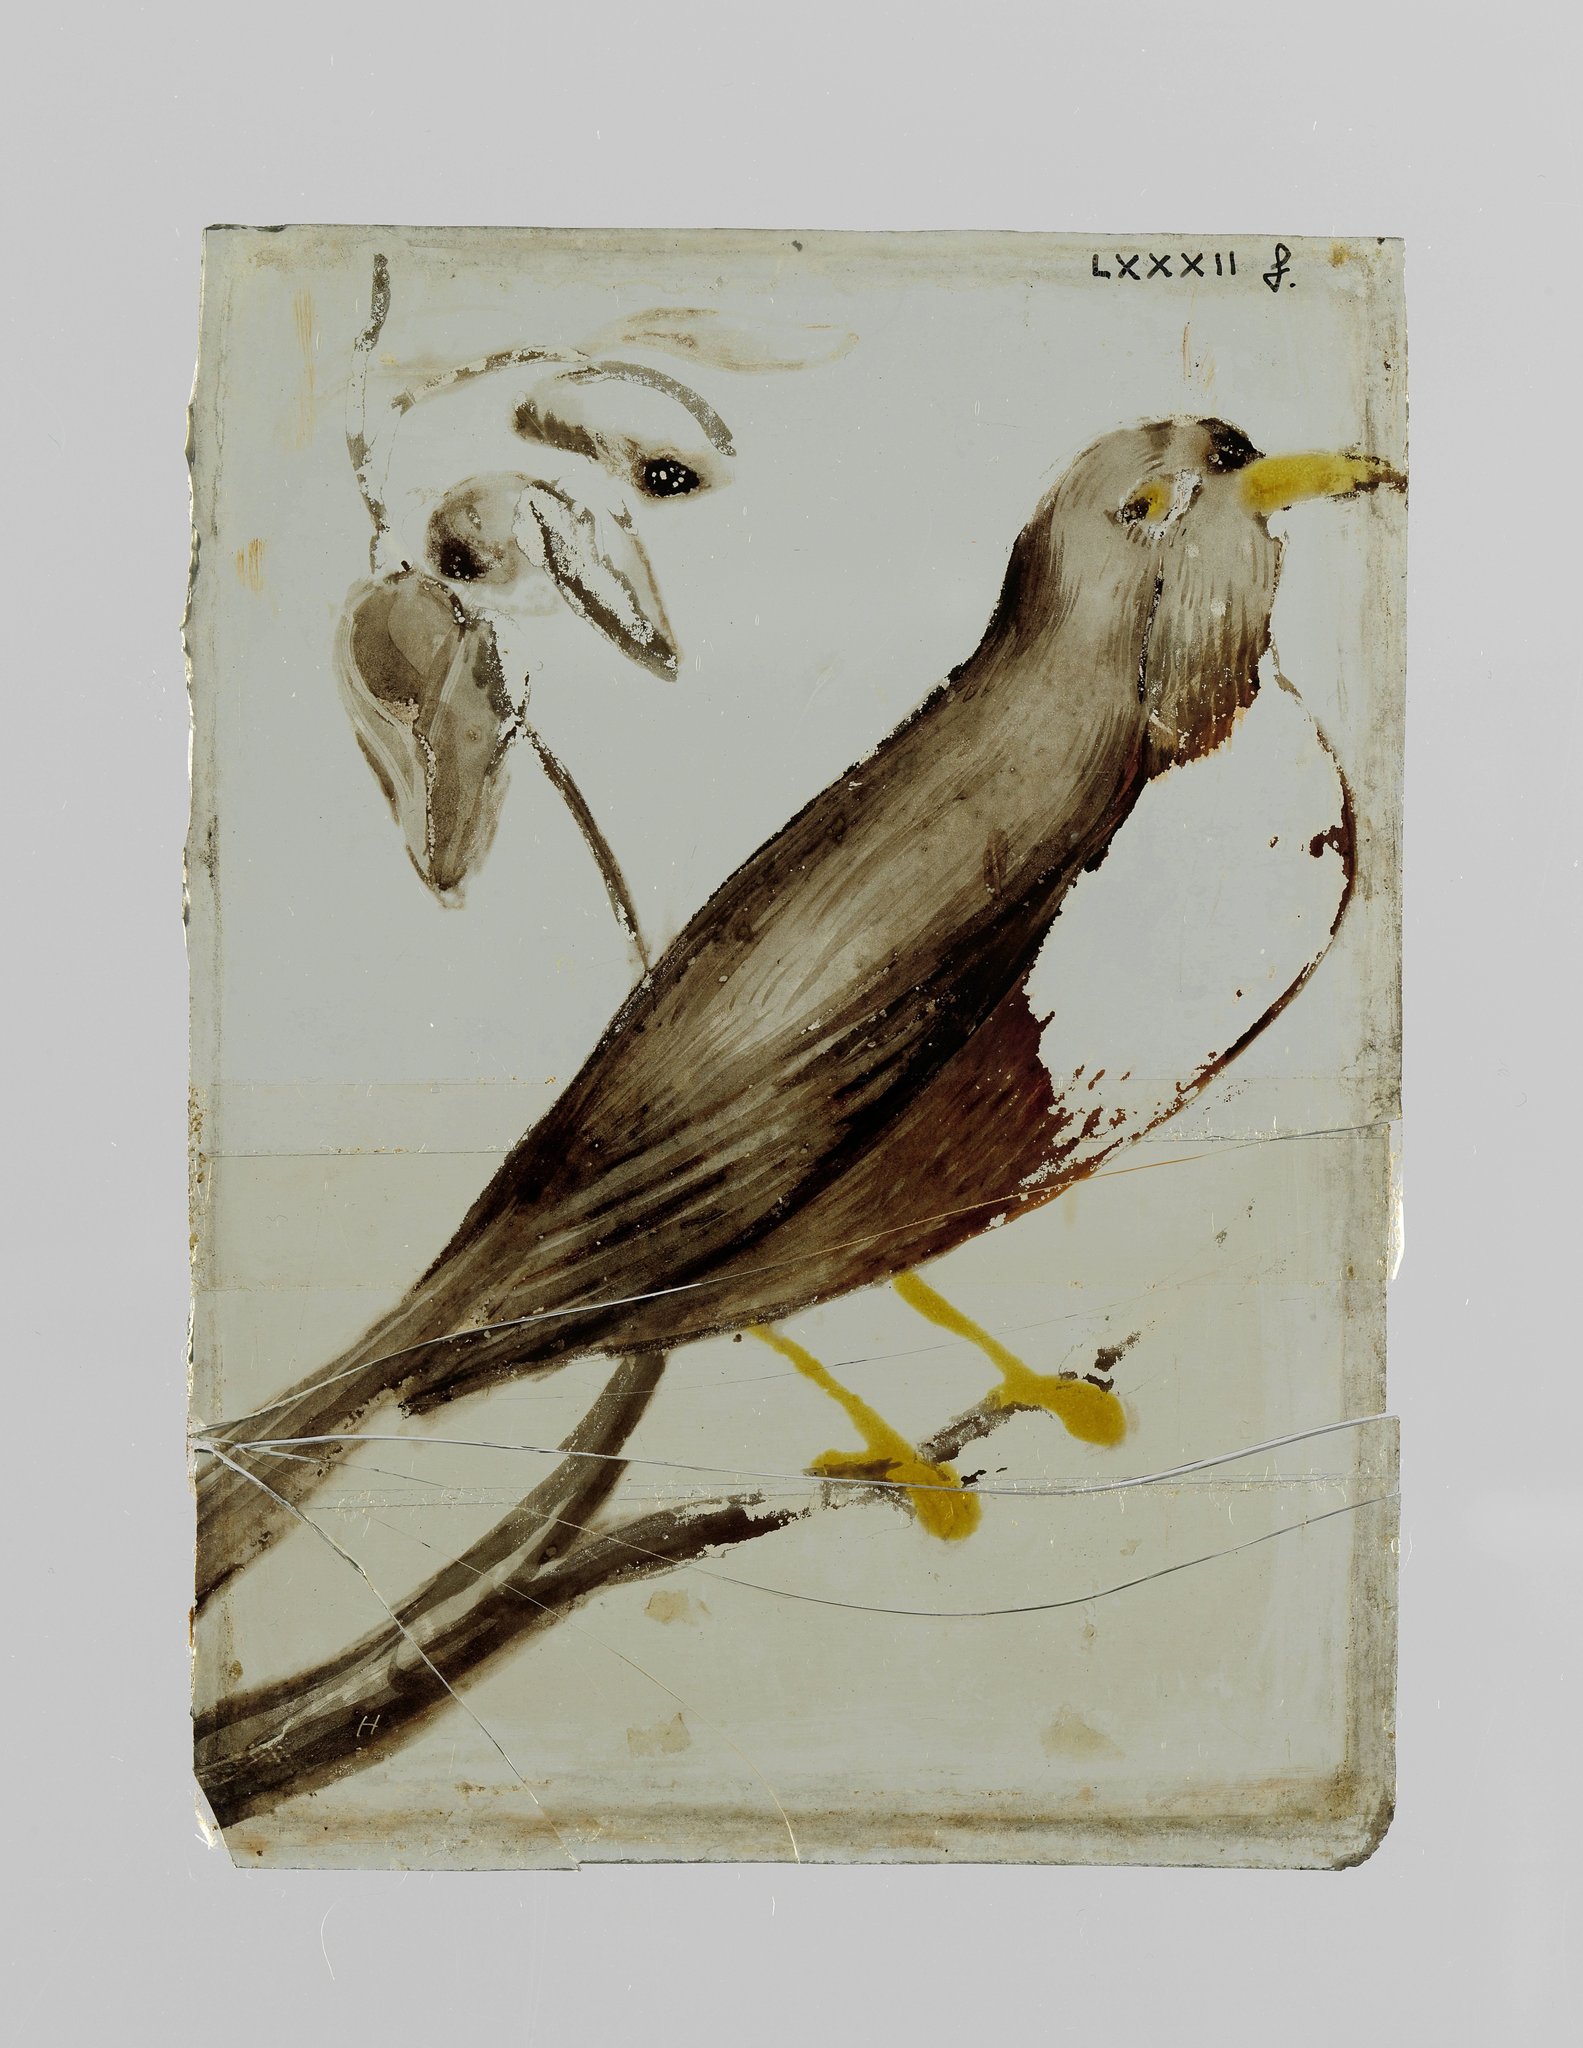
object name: light window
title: Ruit met een vogel op een tak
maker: Anonymous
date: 1650-1675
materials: glass, lead, pigment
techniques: enamel painting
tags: birds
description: Een gebrandschilderd ruit met de afbeelding van een vogel in grisaille en zilvergeel. Deze ruit vertoont een opvallende gelijkenis met BK-LXXX-J.